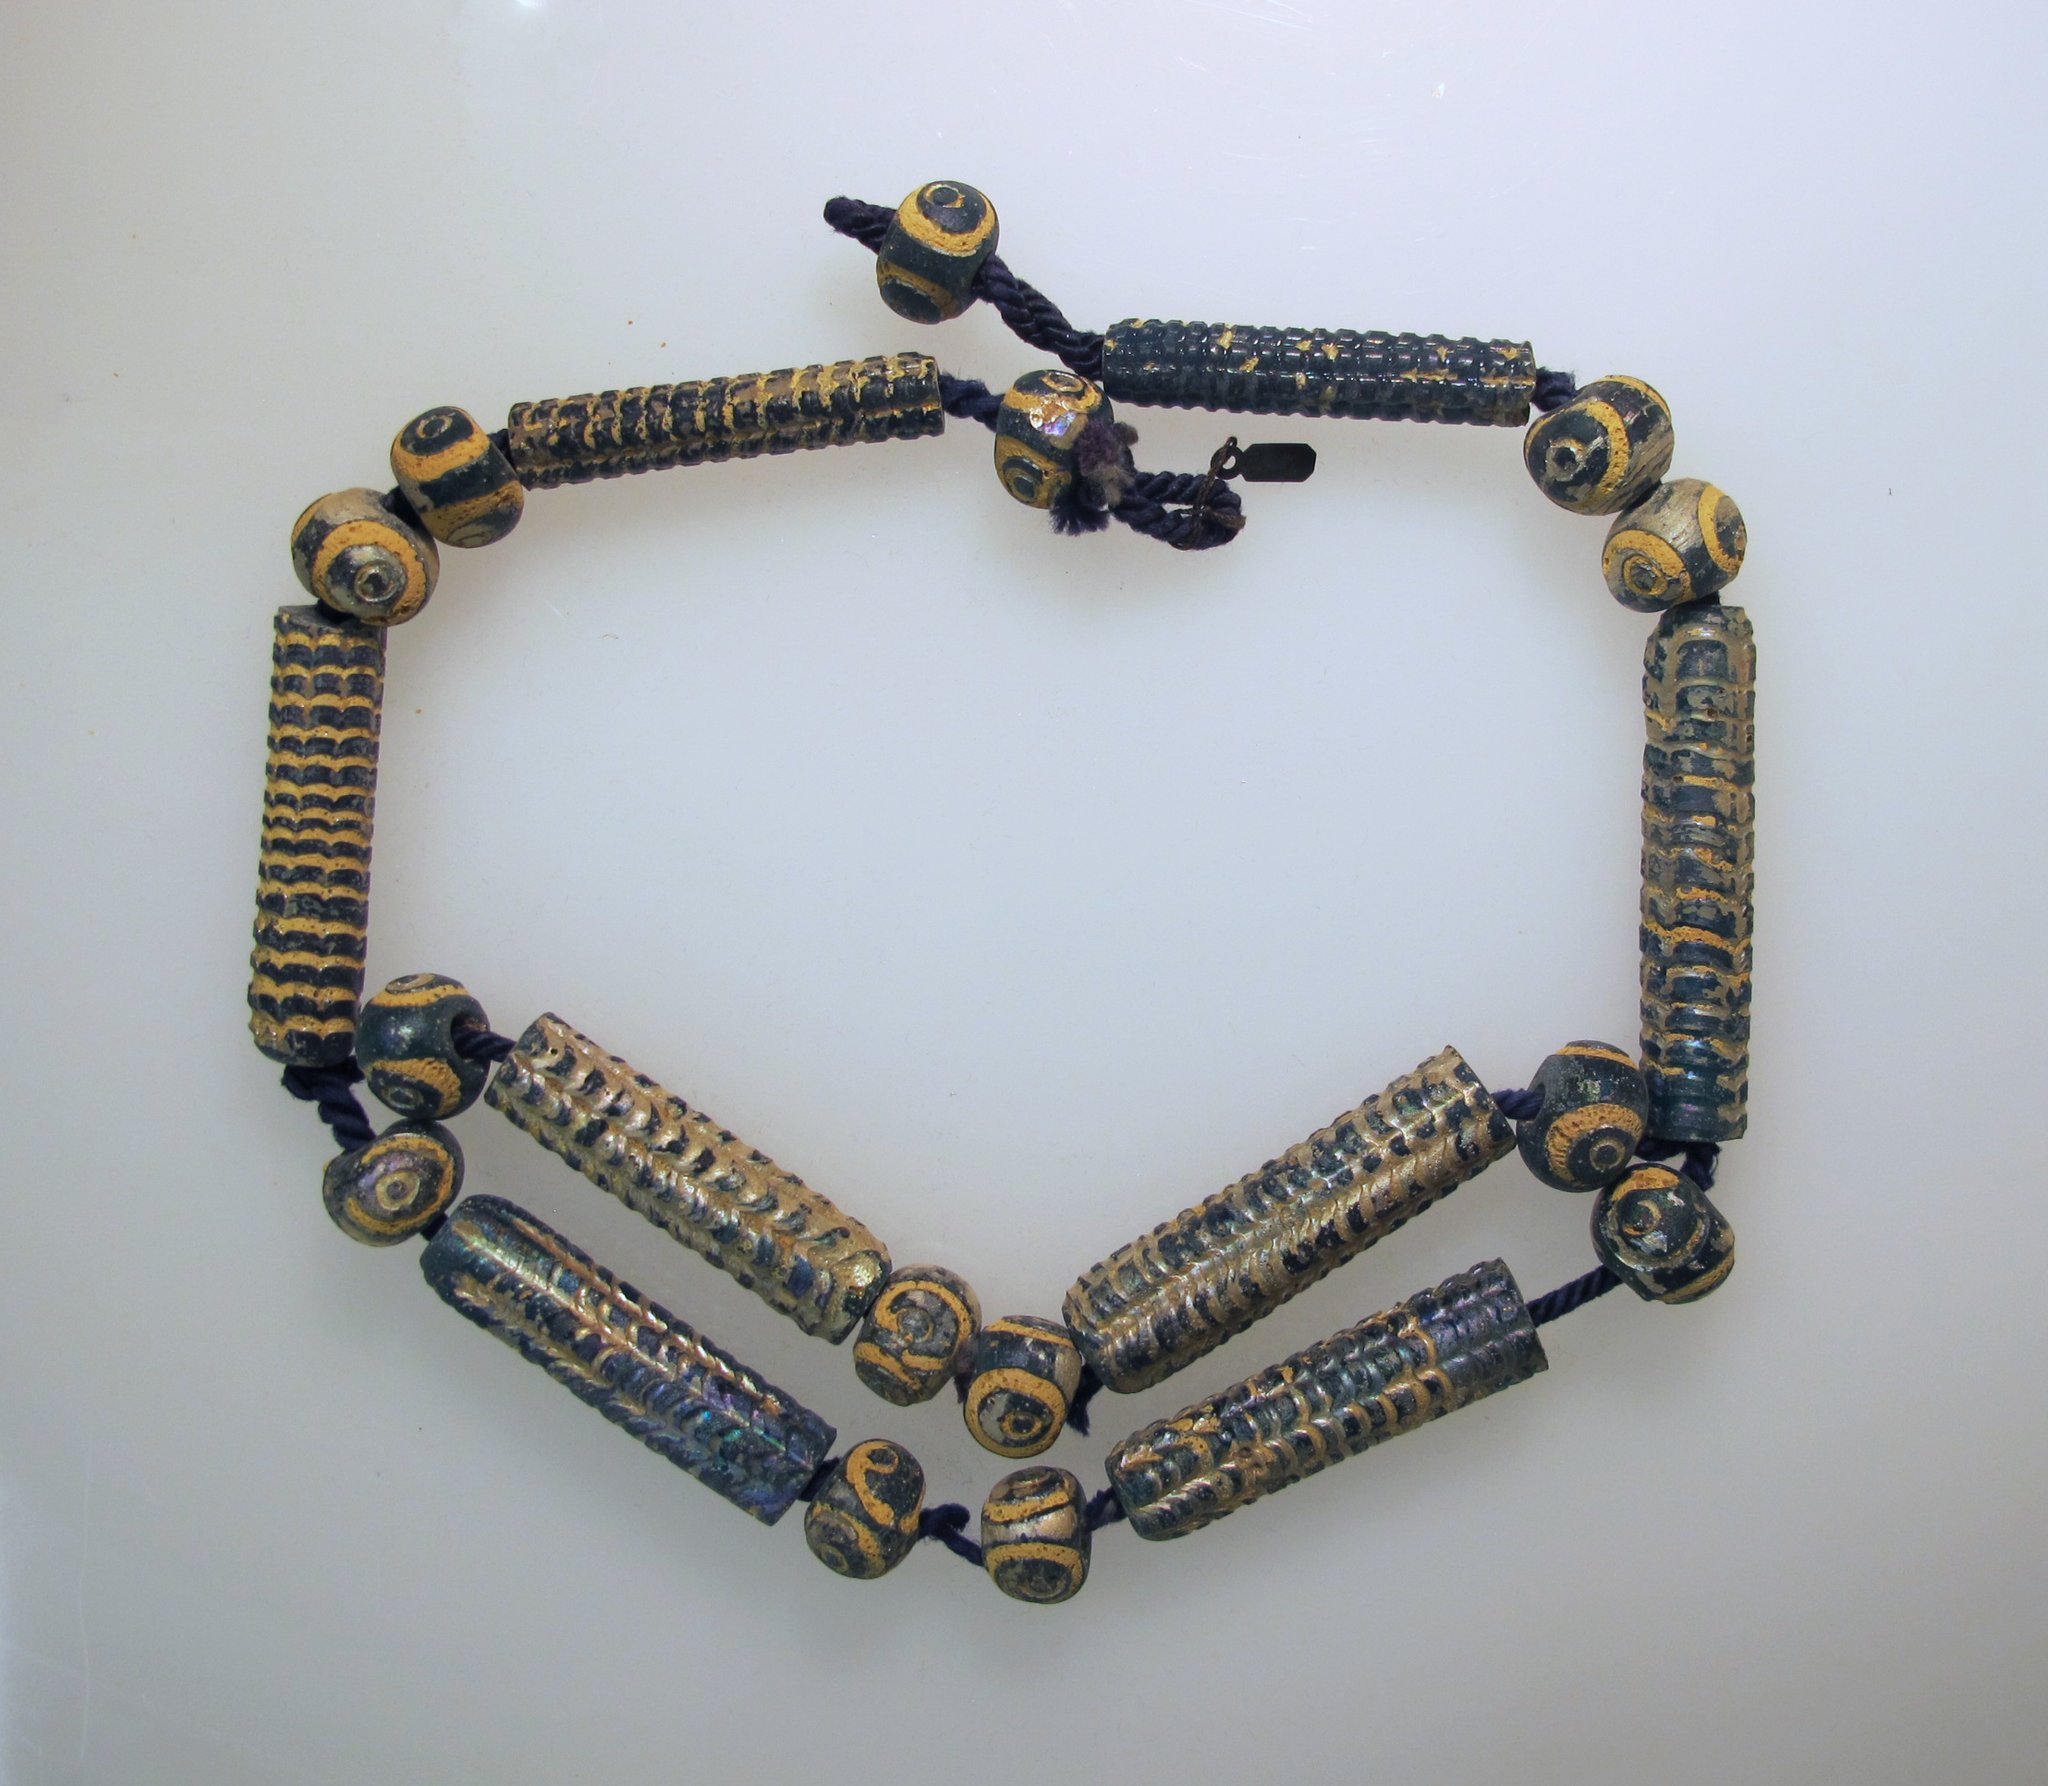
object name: bead, 22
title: Beads, 22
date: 7000 BCE-330 CE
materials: glass